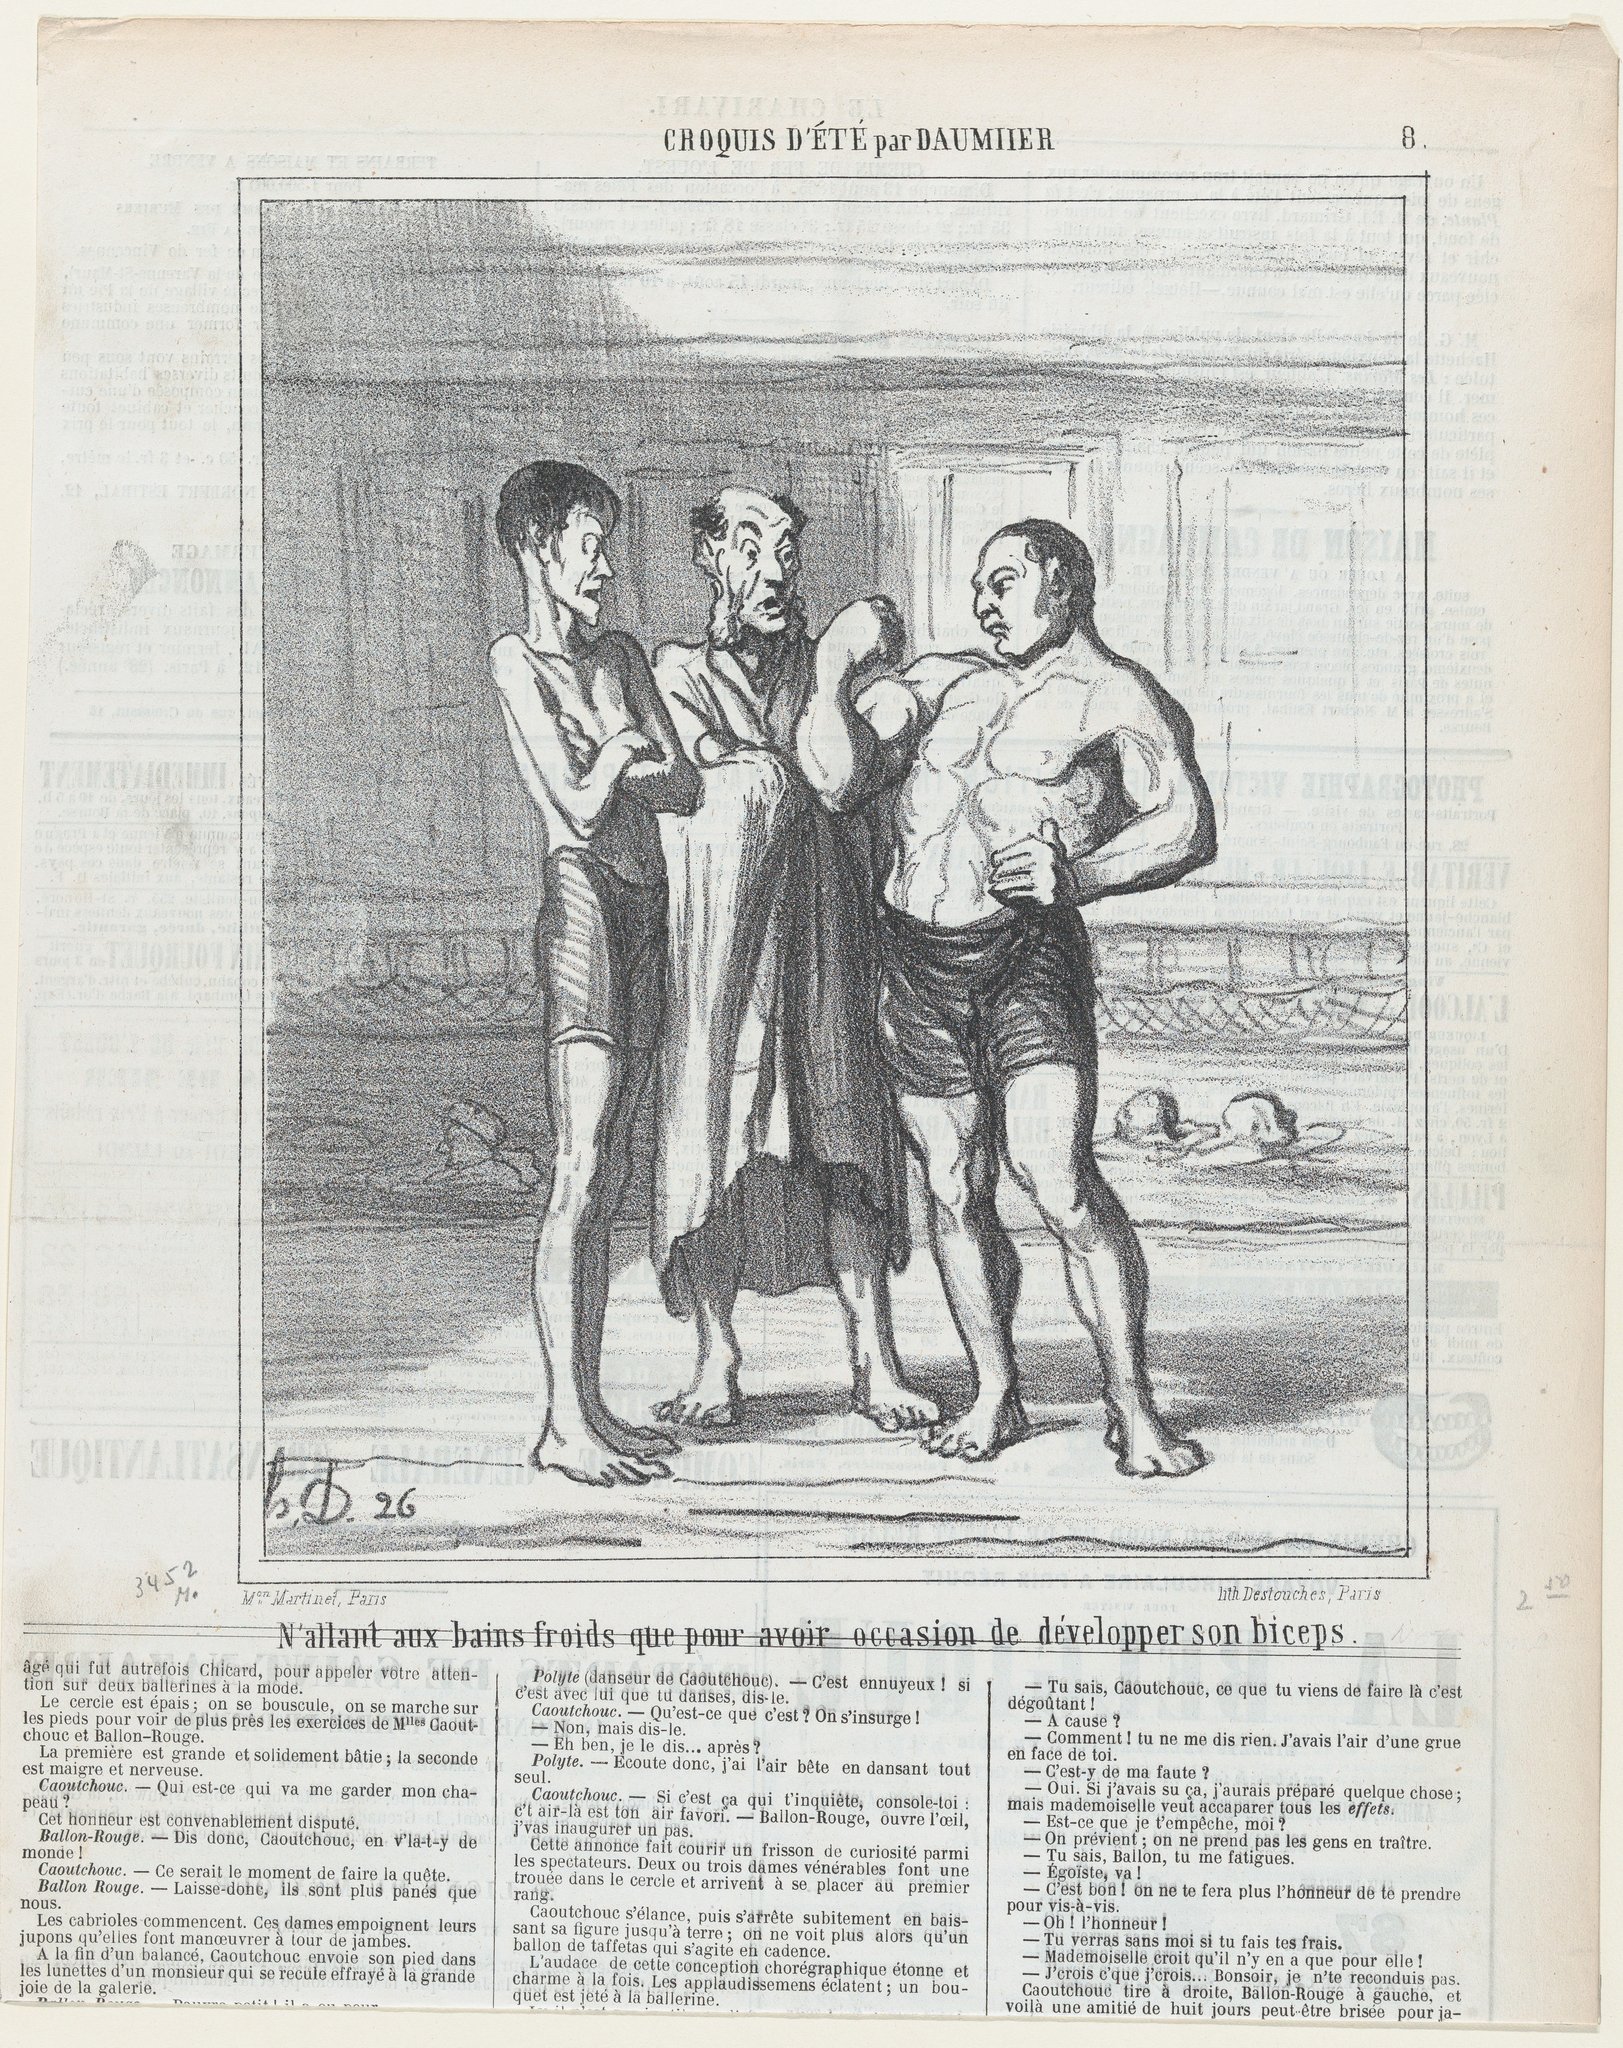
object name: print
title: Going to the swimming pool just for the development of one's muscles, from 'Summer sketches,' published in Le Charivari, August 10, 1865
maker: honoré daumier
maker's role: artist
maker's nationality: french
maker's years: 1808-1879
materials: paper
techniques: lithograph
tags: men